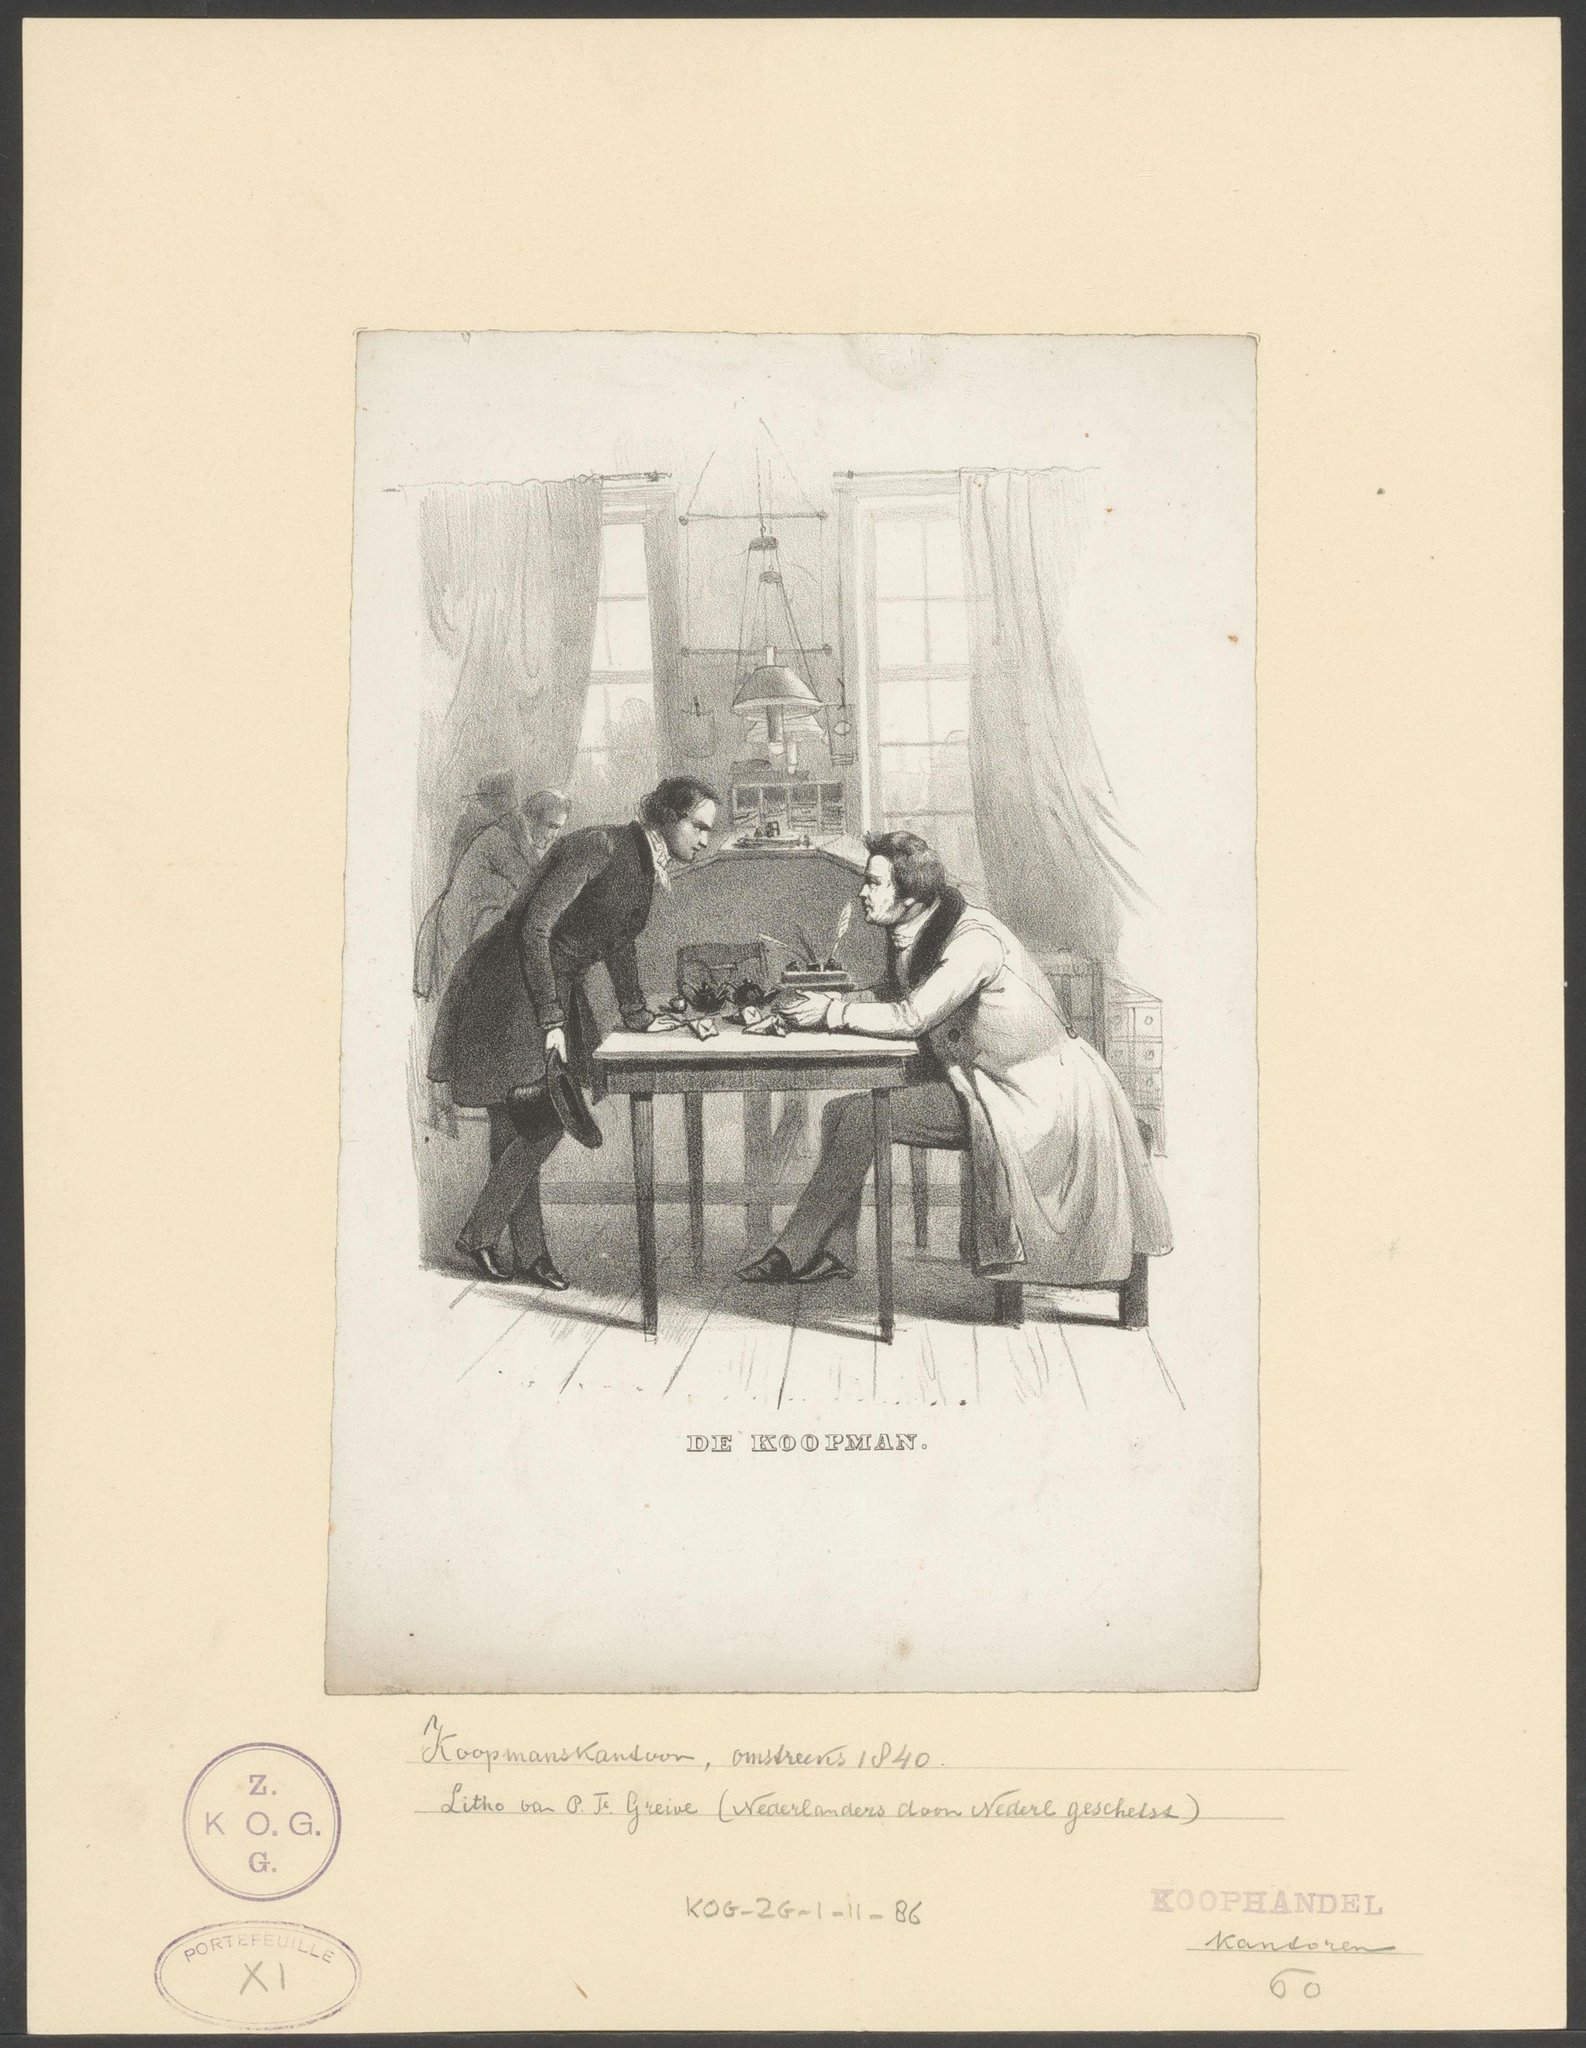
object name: print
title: De koopman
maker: Anonymous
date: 1800-1899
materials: paper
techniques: lithograph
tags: exchange, bourse, merchant, salesman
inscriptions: stamp, stamp, collector's mark: Lugt 1641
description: Twee mannen aan een tafel in een wisselkantoor kijken elkaar strak aan. Onderwerpsrubrieken binnen de Atlas Zeden en Gewoonten: Handel, nijverheid en verkeer, Koophandel, Veilingen, Makelaardij en Verzekeringswezen. Kamers te huur.